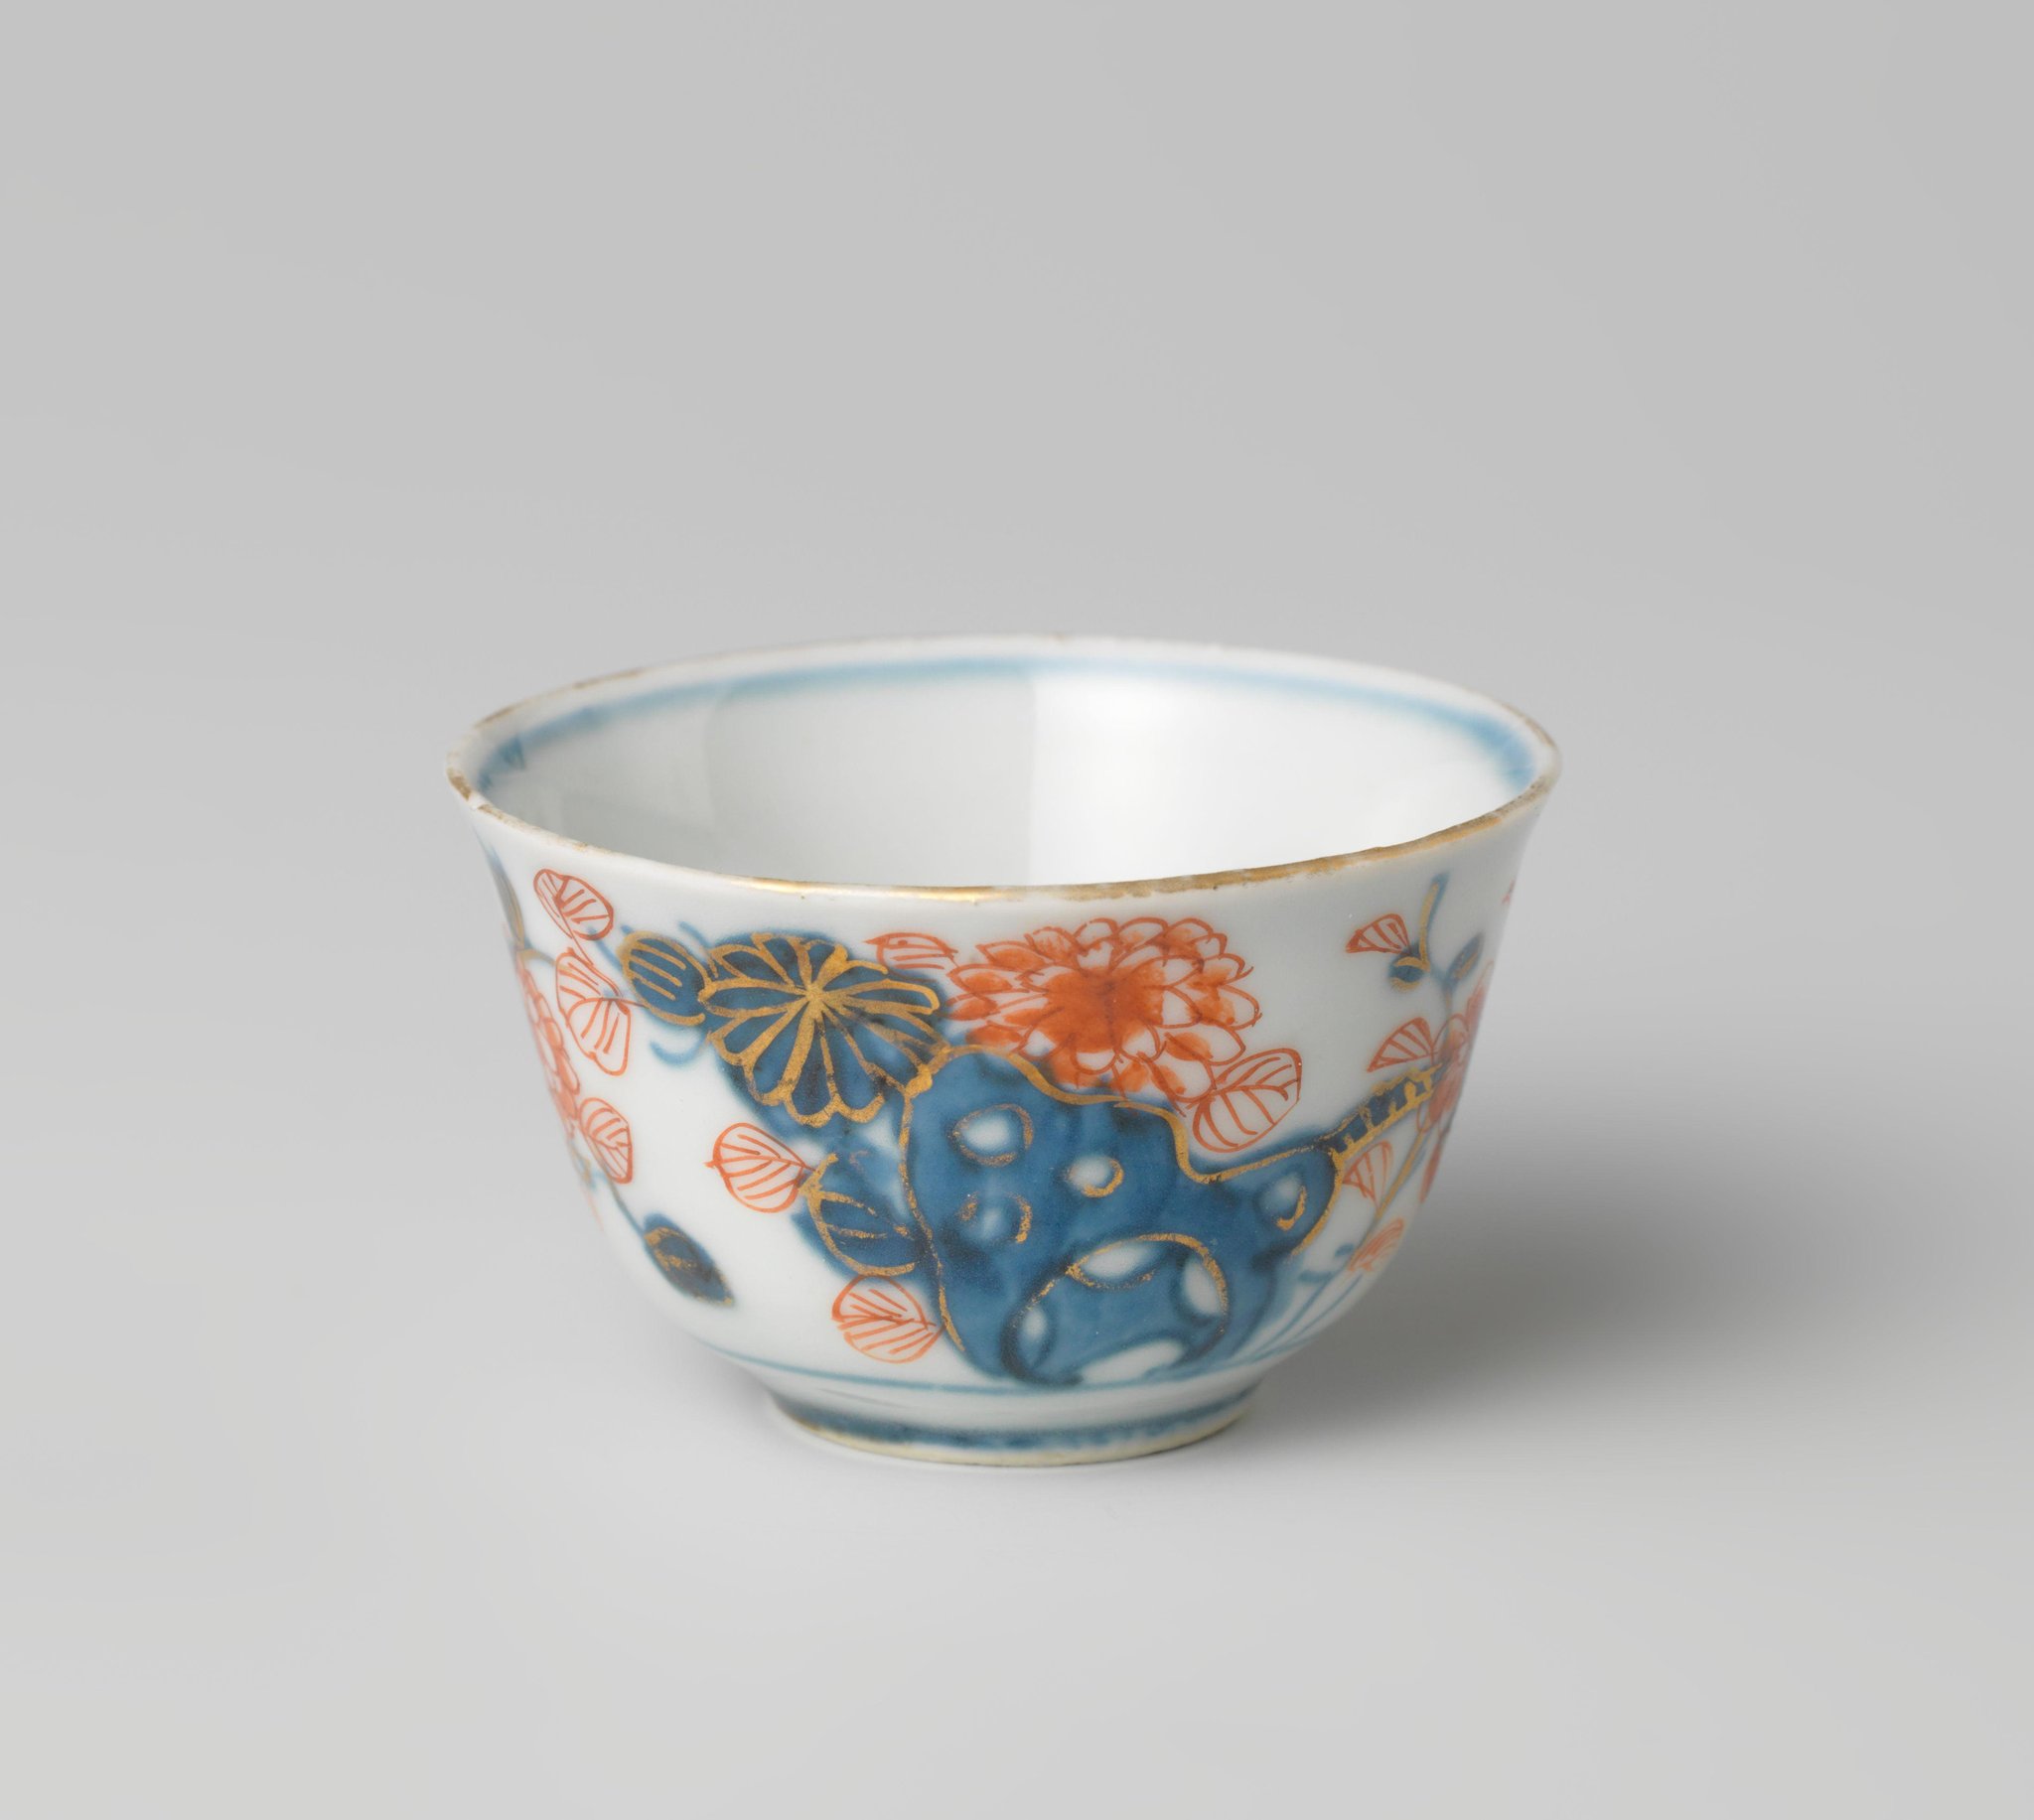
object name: cup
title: Cup with butterflies and flowering plants near a rock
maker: Anonymous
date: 1725-1749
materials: cobalt, glaze, gold, paint, porcelain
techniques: firing, gilding, turning, vitrification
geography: china